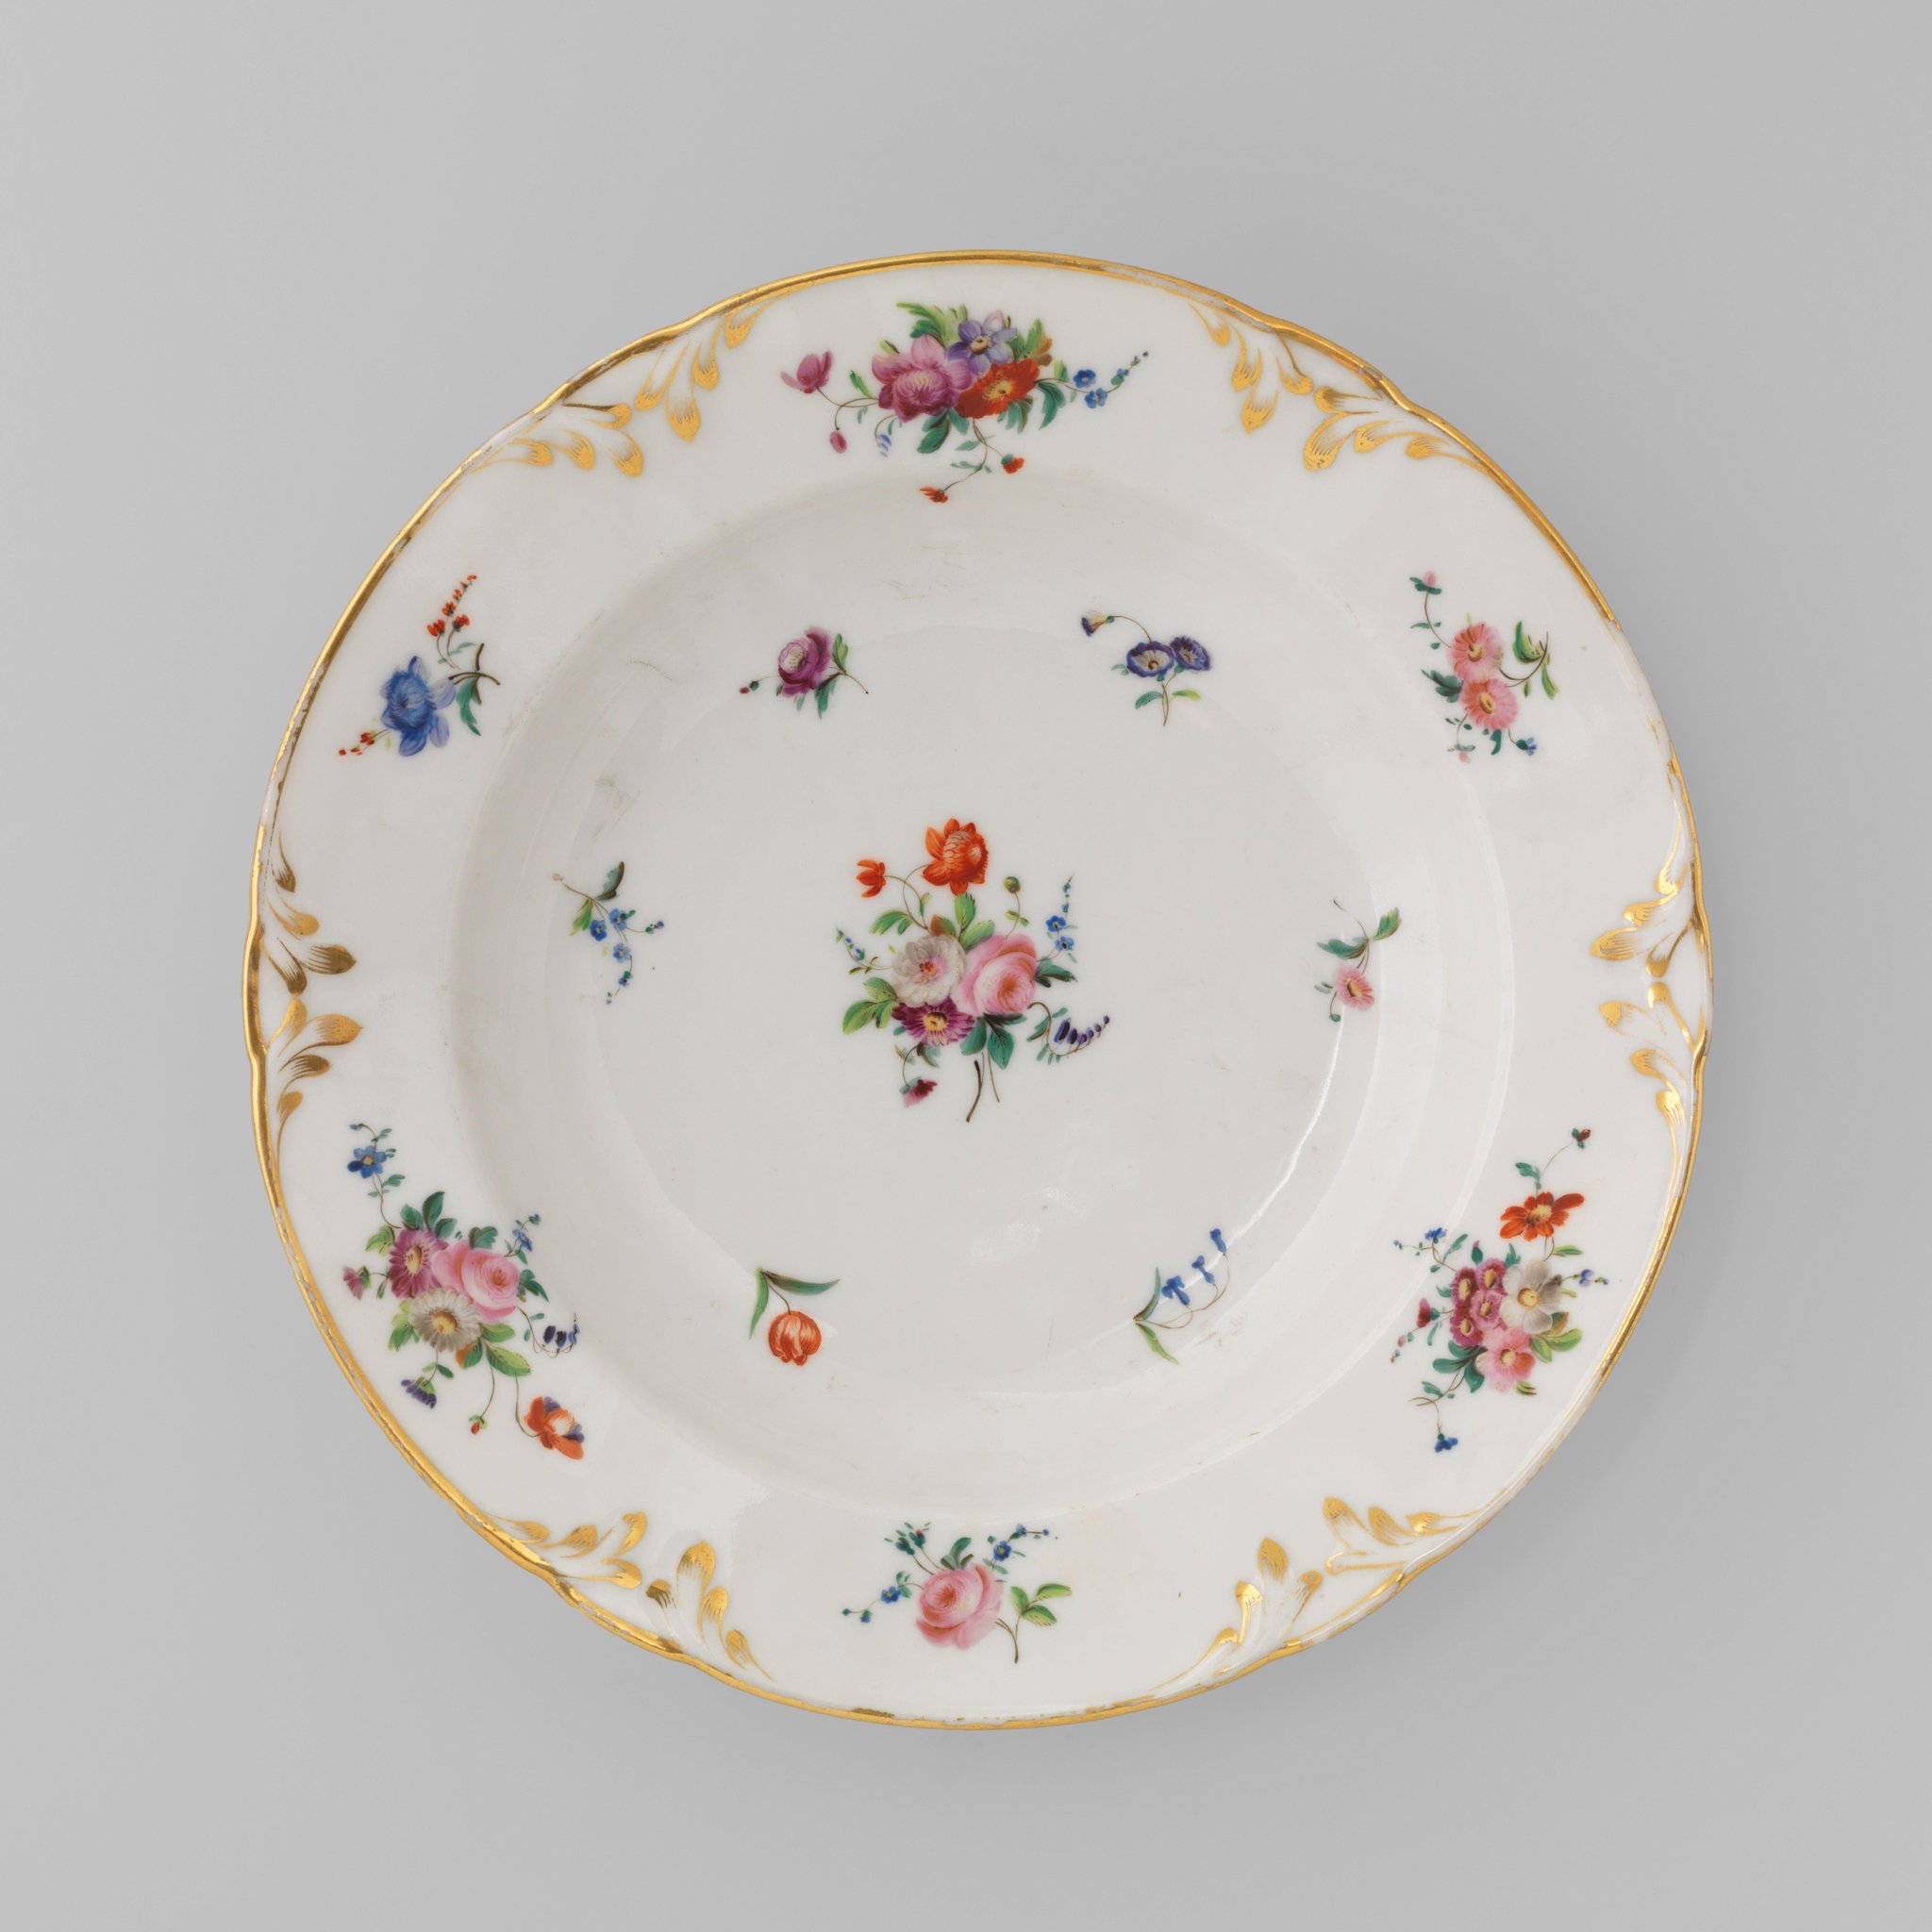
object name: service set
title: Plate with bouquets and flower sprays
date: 1839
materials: glaze, gold, paint, porcelain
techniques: firing, forming, gilding, turning, vitrification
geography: paris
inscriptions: mark: ‘DENUELLE/ Boulevard St. Denis 18/ à Paris’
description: Diep bord van porselein met een gelobde rand, beschilderd op het glazuur in blauw, rood, roze, groen, geel, paars, zwart en goud. Op het plat boeketten van verschillende bloemen en strooibloemen. Vanuit de gelobde, gouden rand, gemodelleerde bladranken in reliëf, aangezet met goud. Hiertussen boeketten. Drie proenen op de onderzijde. Gemerkt op de onderzijde met 'DENUELLE/ Boulevard St. Denis 18/ à Paris'.